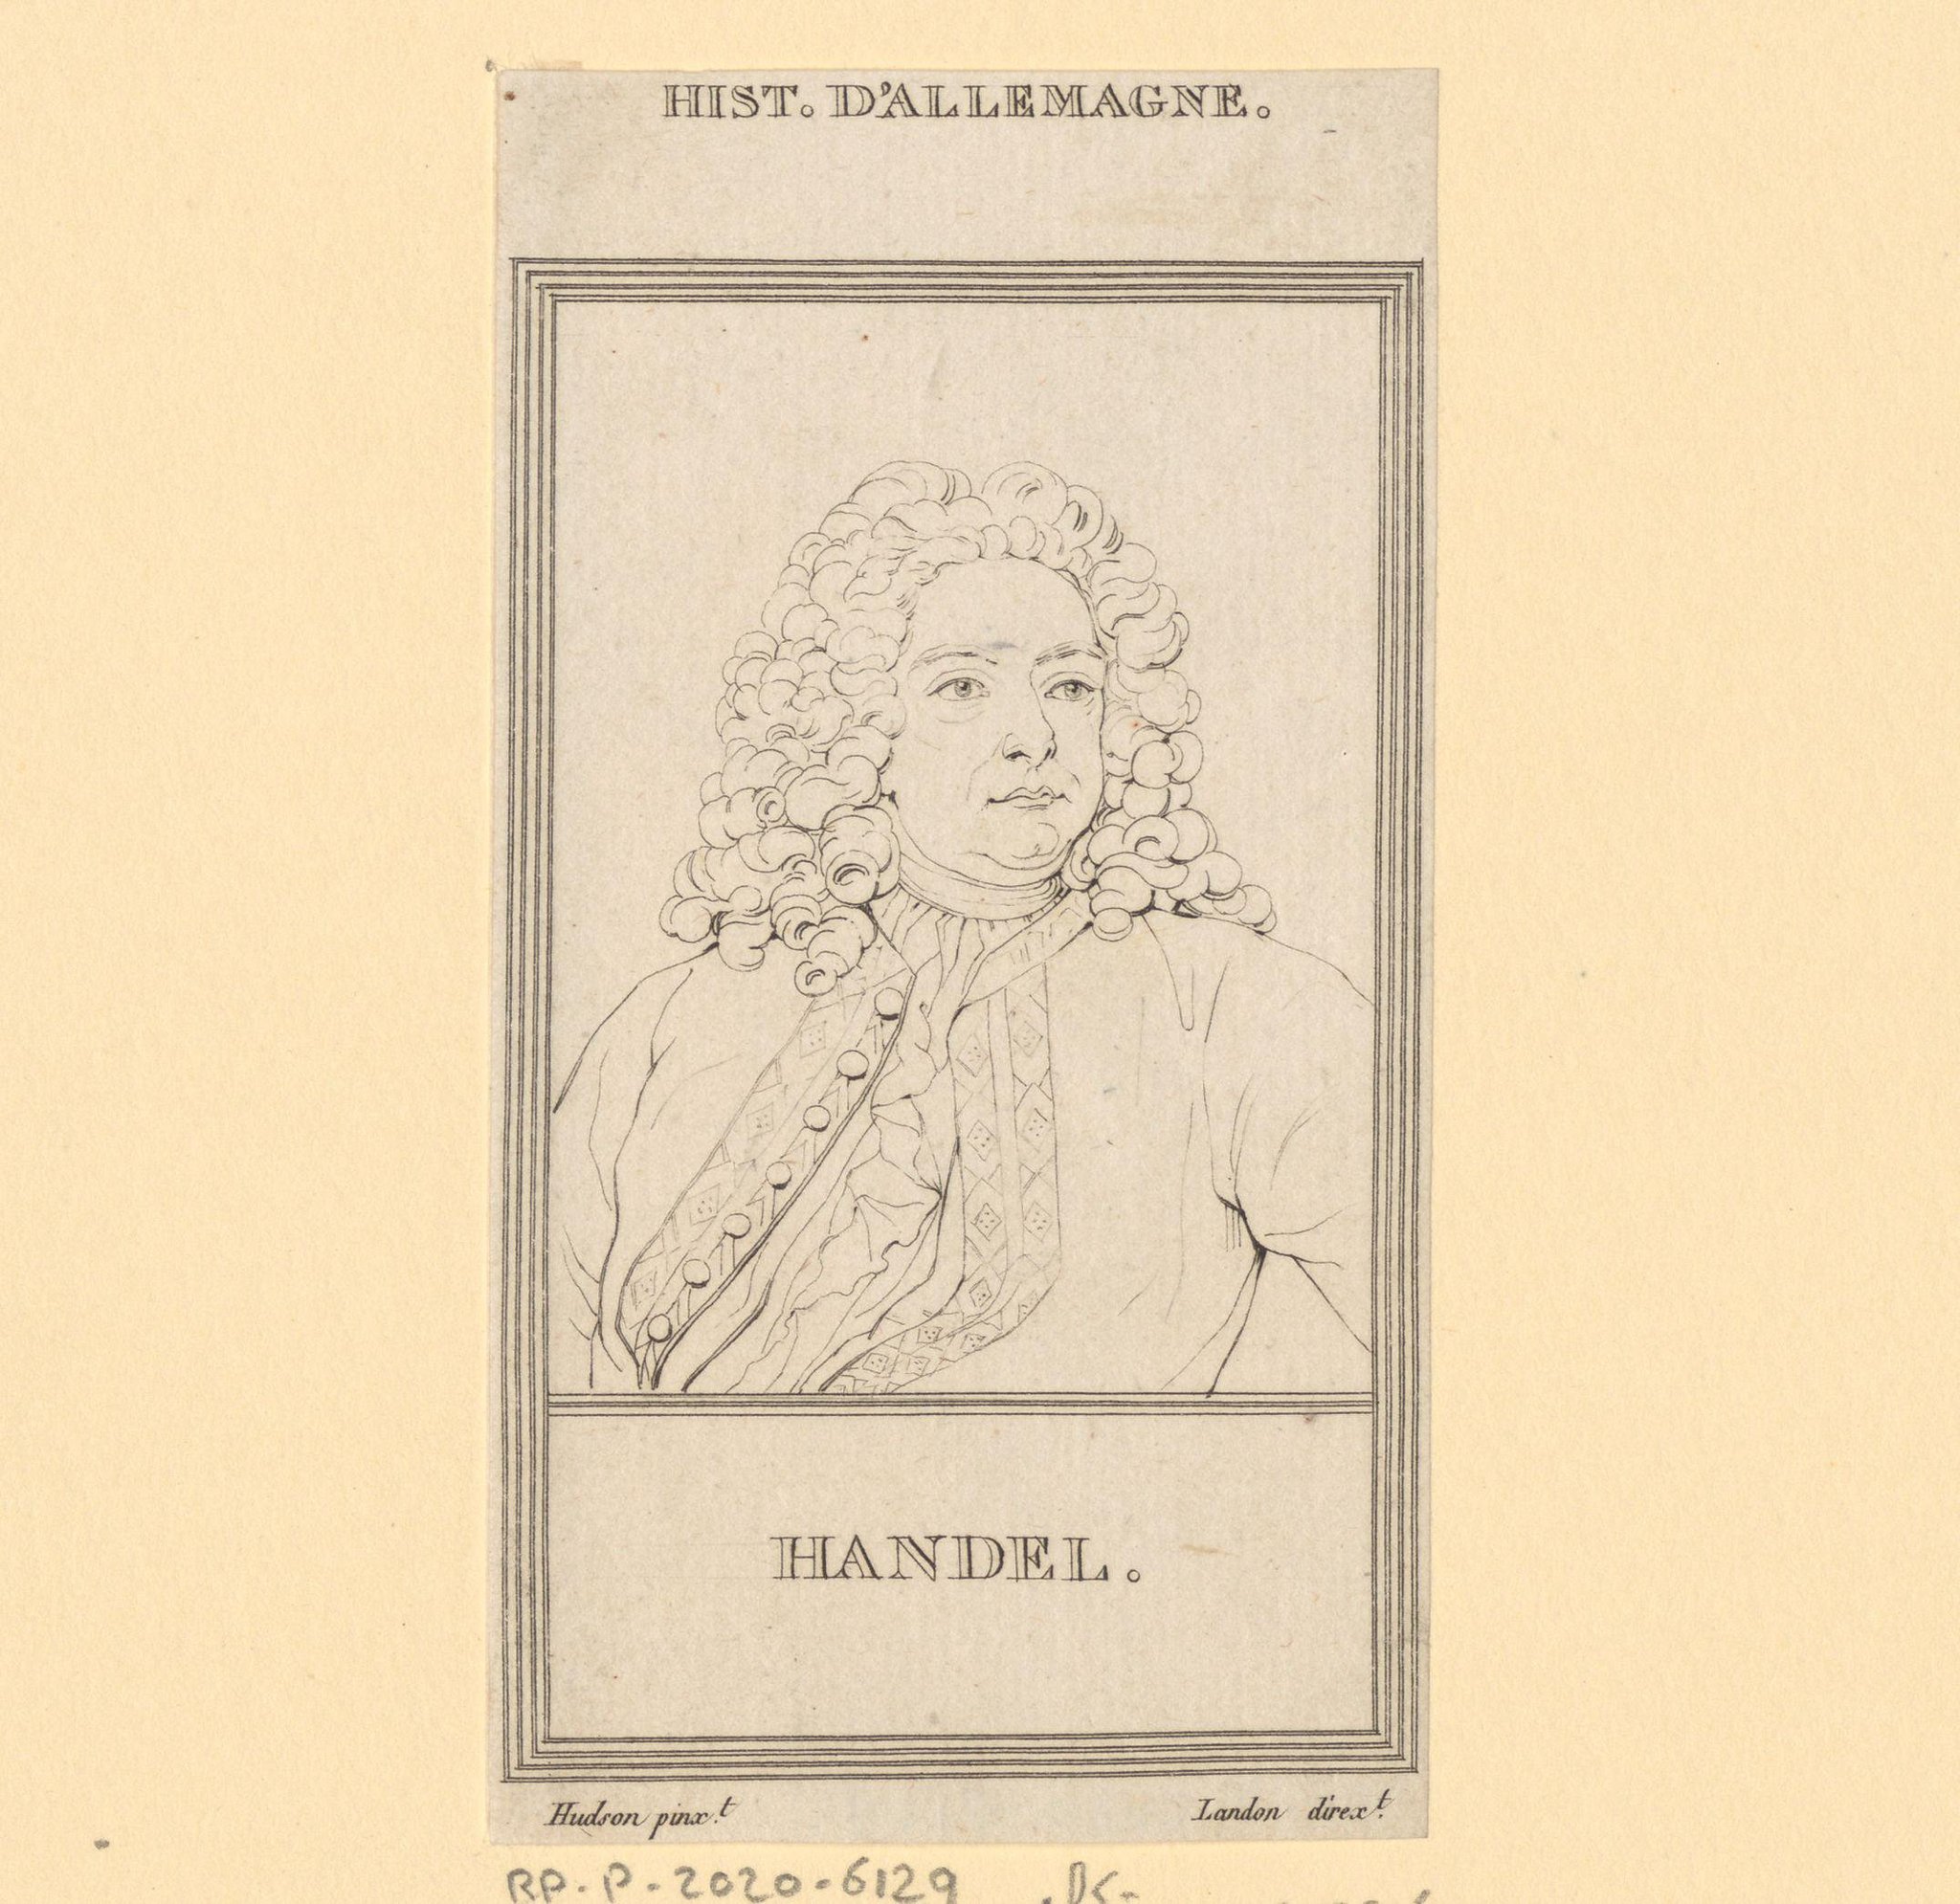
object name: book illustration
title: Portret van Georg Friedrich Händel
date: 1805-1811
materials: paper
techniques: etching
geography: paris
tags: london, historical persons, portrait of composer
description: Prent uit: Galerie historique des hommes les plus célèbres (...). Parijs: Charles Paul Landon, 1805-1811.